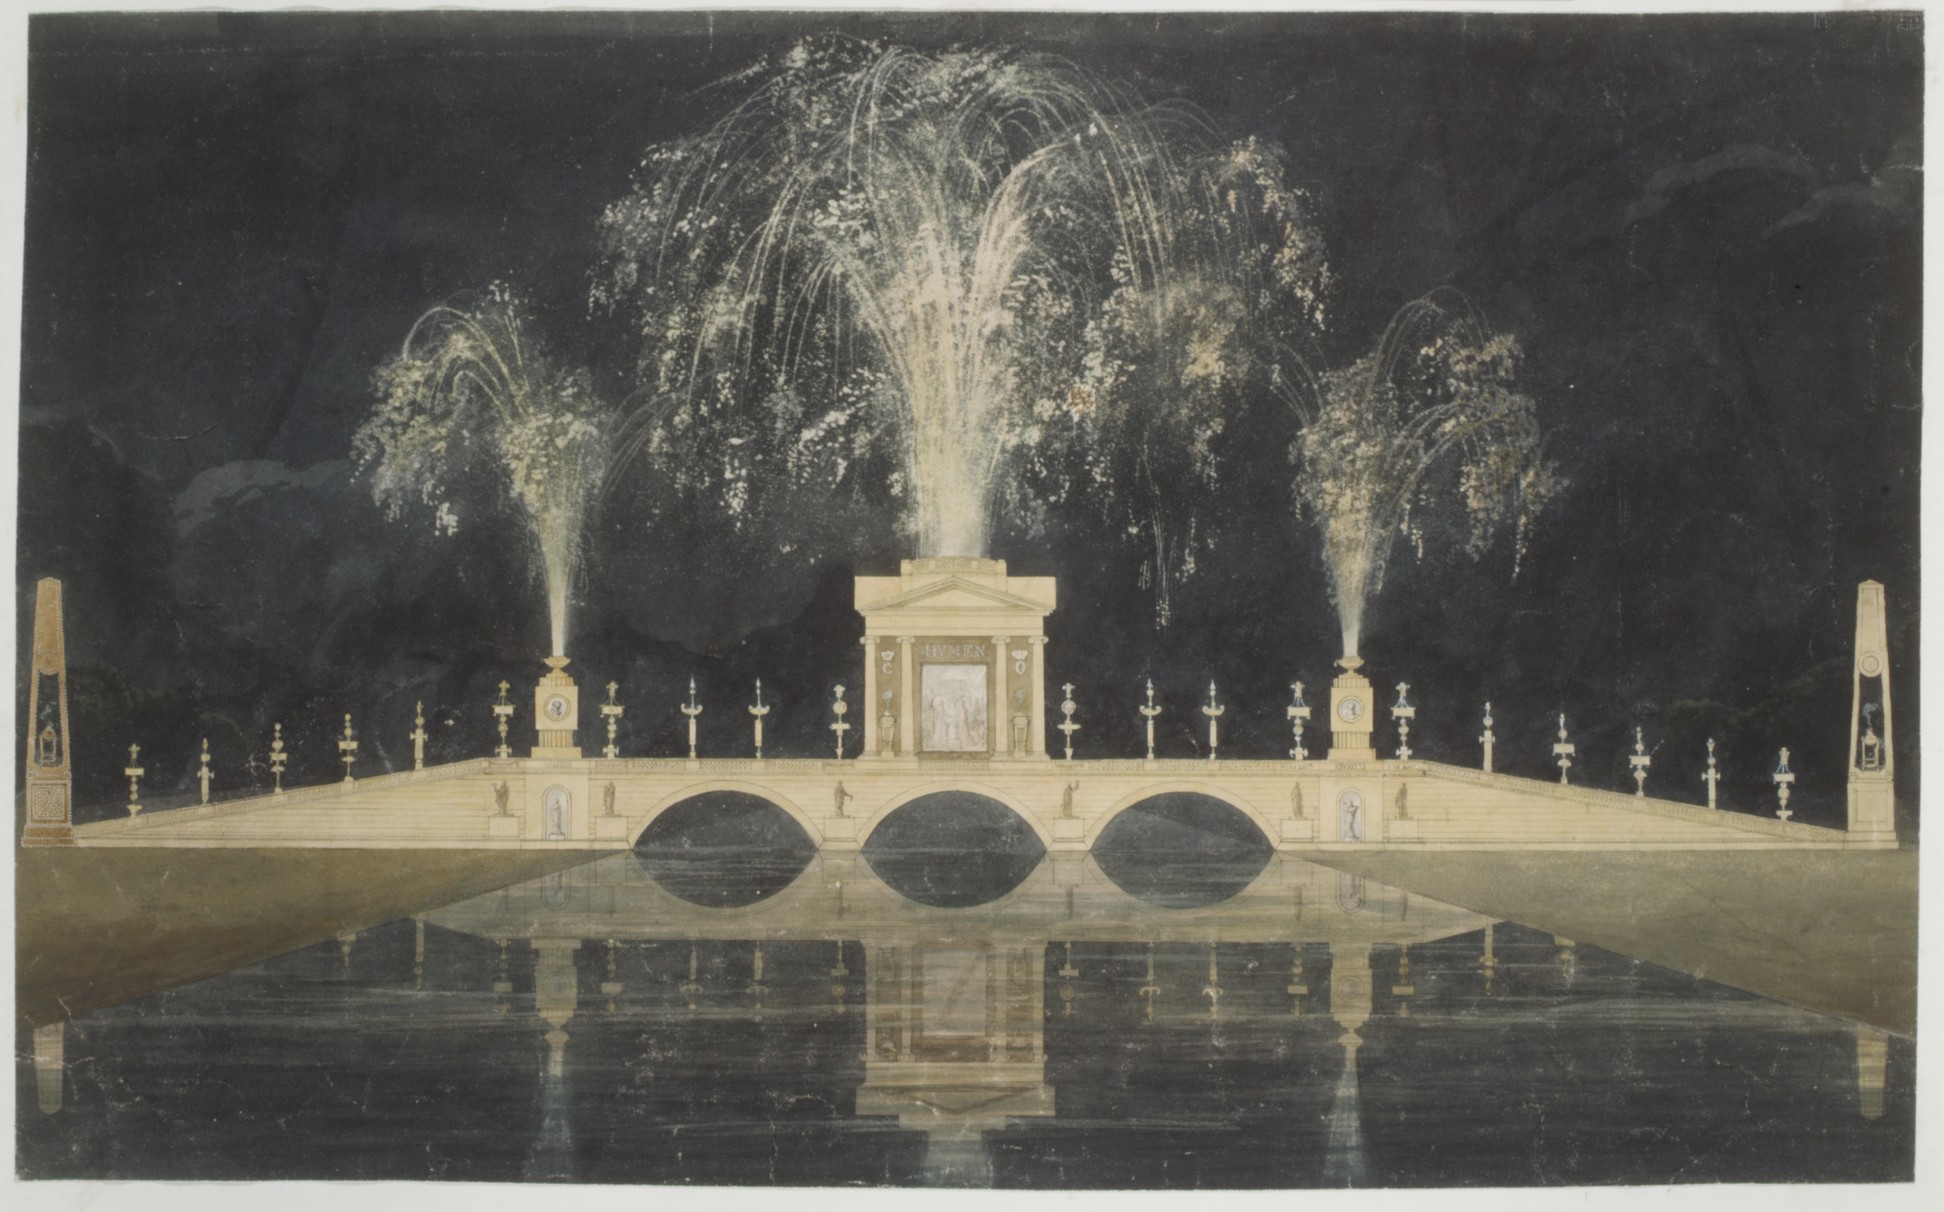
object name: drawing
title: Engagement of Princess Charlotte to William of Orange, London, 1813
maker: anonymous, british, 19th century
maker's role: artist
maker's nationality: british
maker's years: 1800-1900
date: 1813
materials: gouache, graphite, ink, watercolor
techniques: pen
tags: bridges,fireworks,london